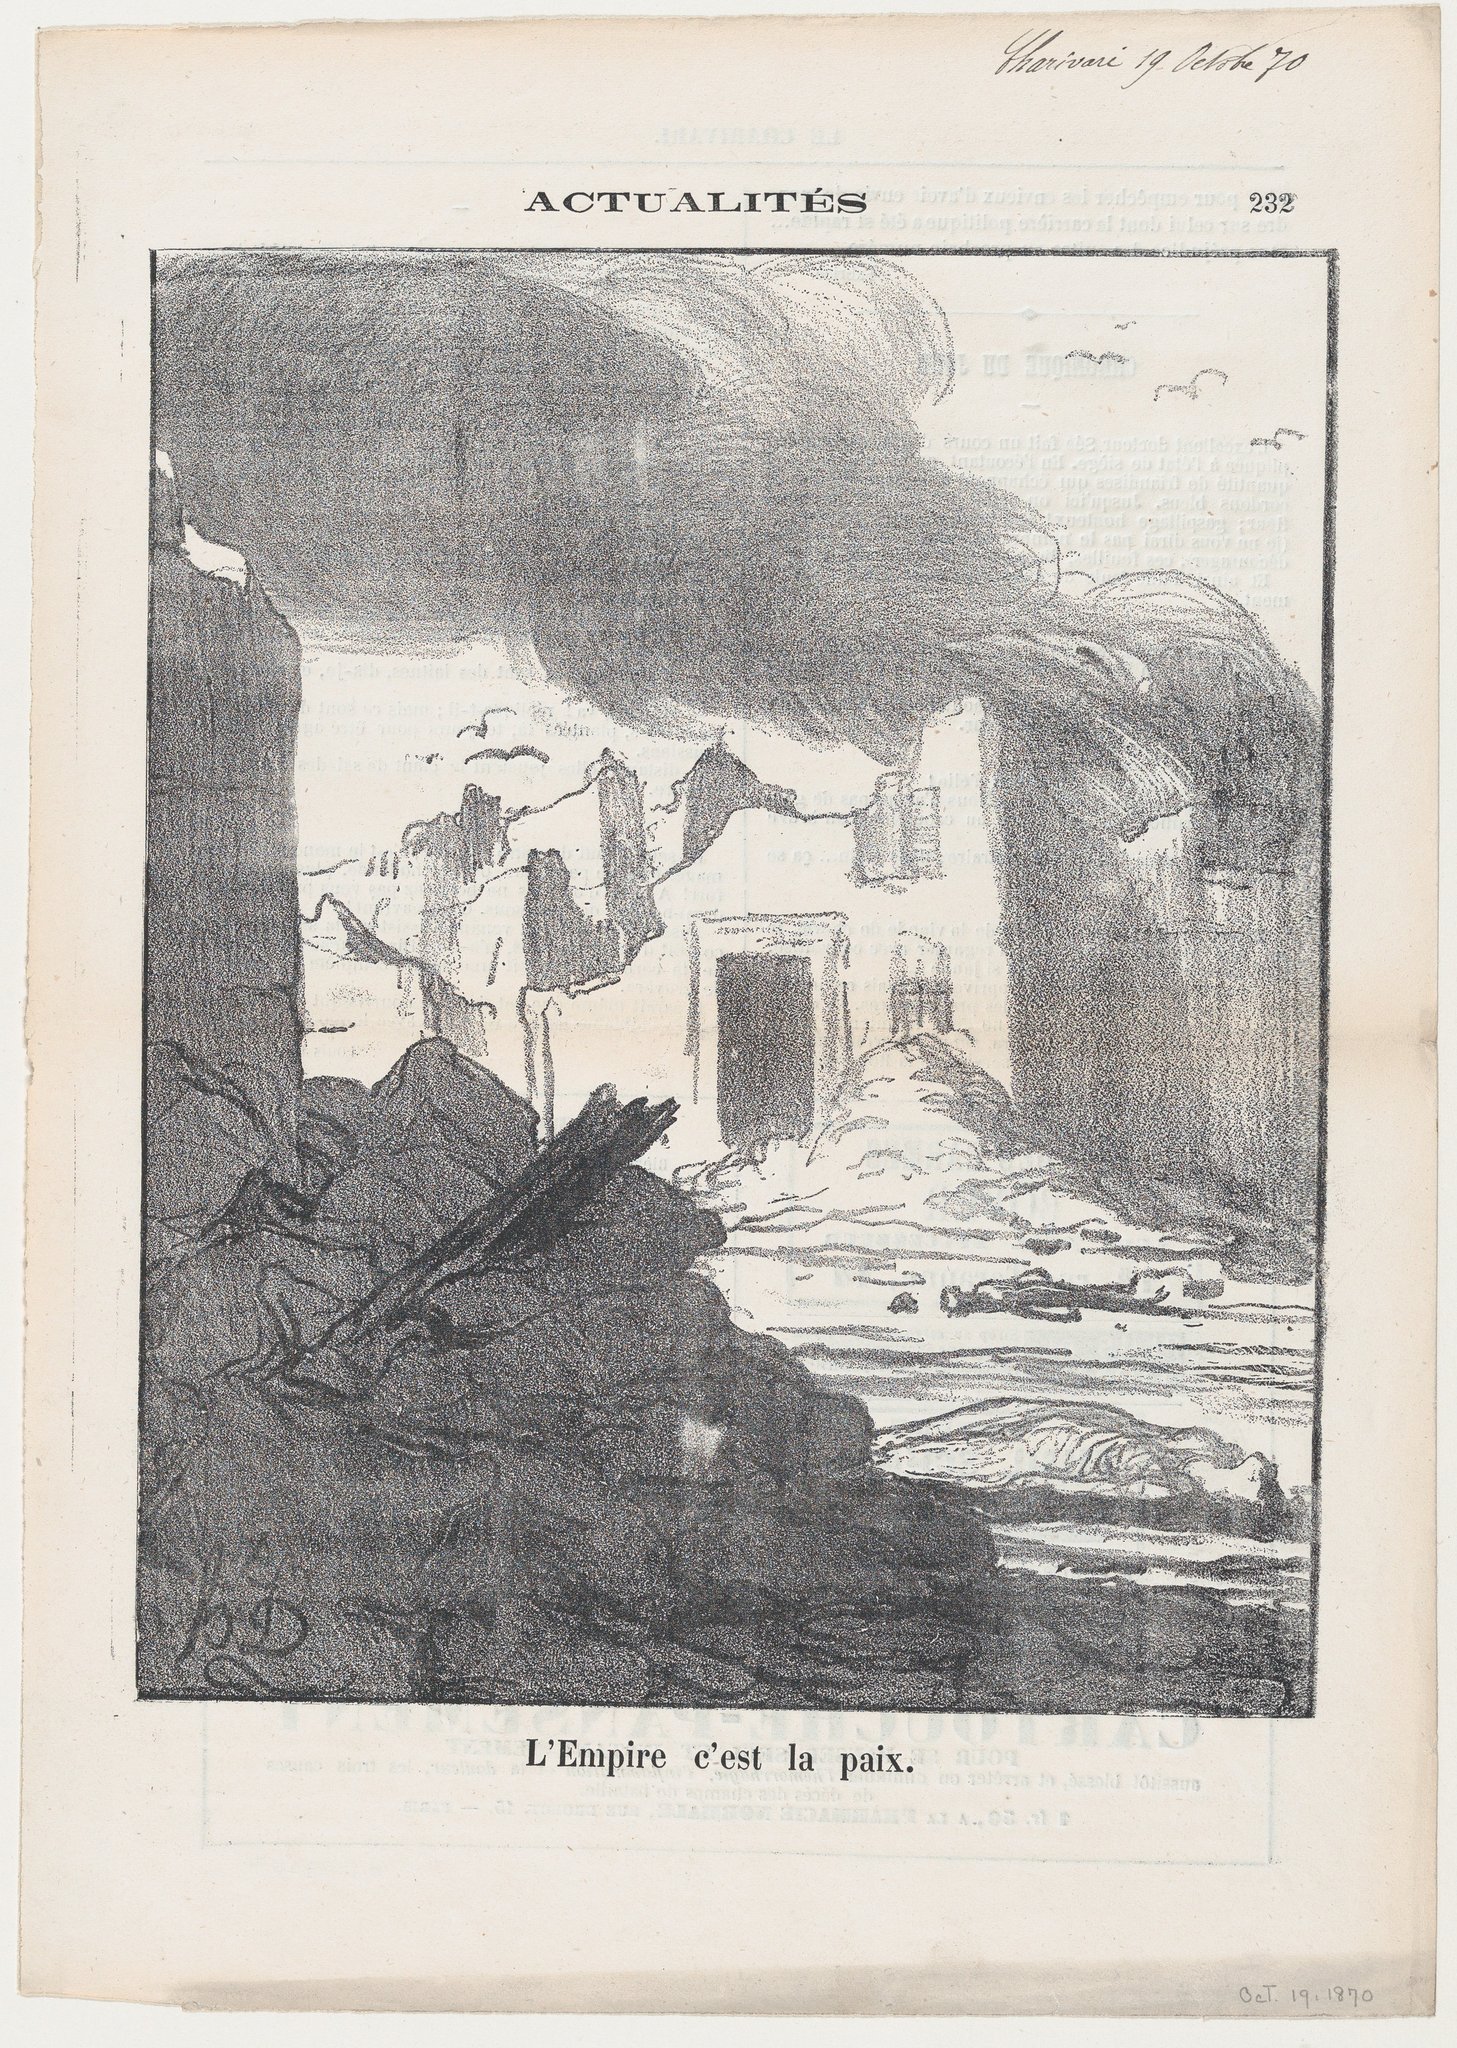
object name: print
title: The Empire means Peace, from 'News of the day,' published in Le Charivari, October 19, 1870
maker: honoré daumier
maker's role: artist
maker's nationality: french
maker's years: 1808-1879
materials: paper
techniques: lithograph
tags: satire